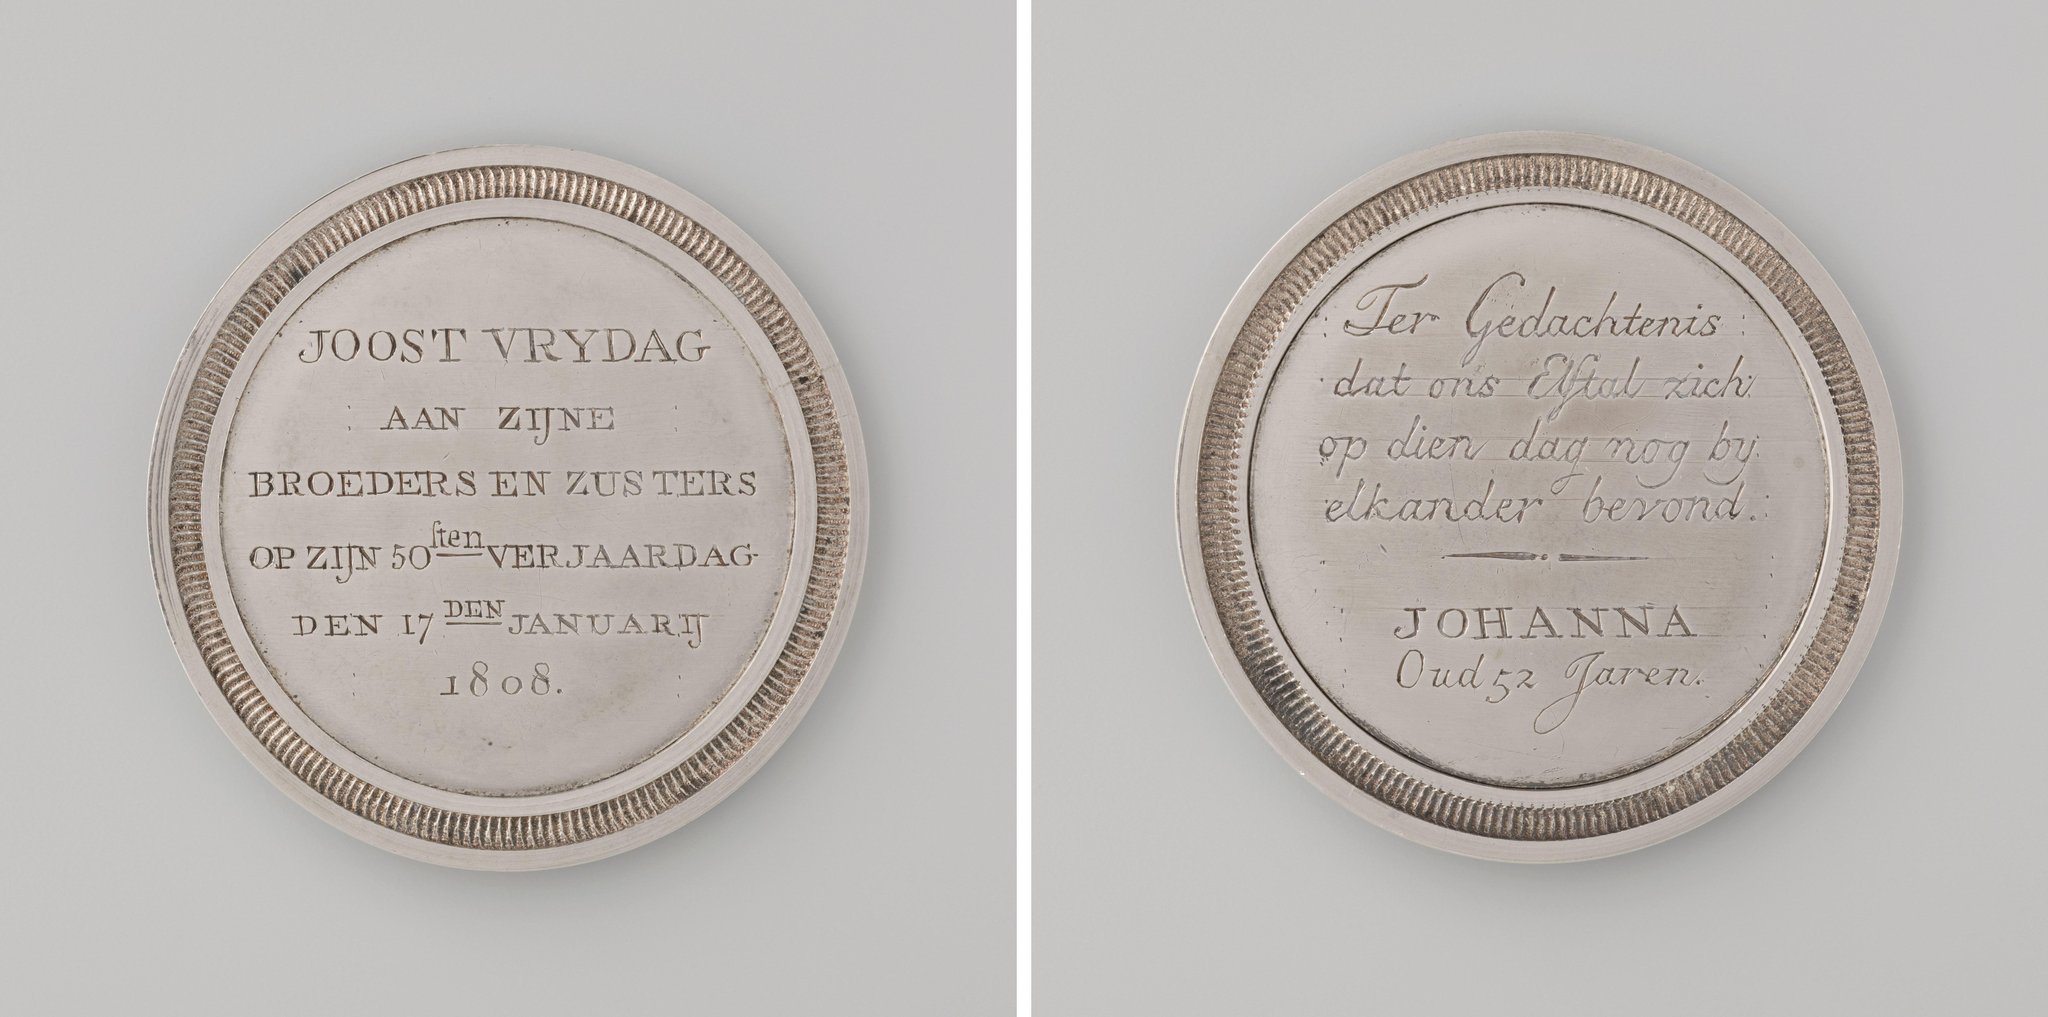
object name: family medal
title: Vijftigste verjaardag van Joost Vrydag, ter herdenking van het feit dat de elf kinderen Vrydag op dat moment nog in leven waren, penning vereerd aan Johanna Vrydag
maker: Anonymous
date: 1808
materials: silver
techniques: engraving, striking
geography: netherlands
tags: joost vrydag, johanna vrydag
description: Zilveren penning. Voorzijde: opschrift. Keerzijde: opschrift